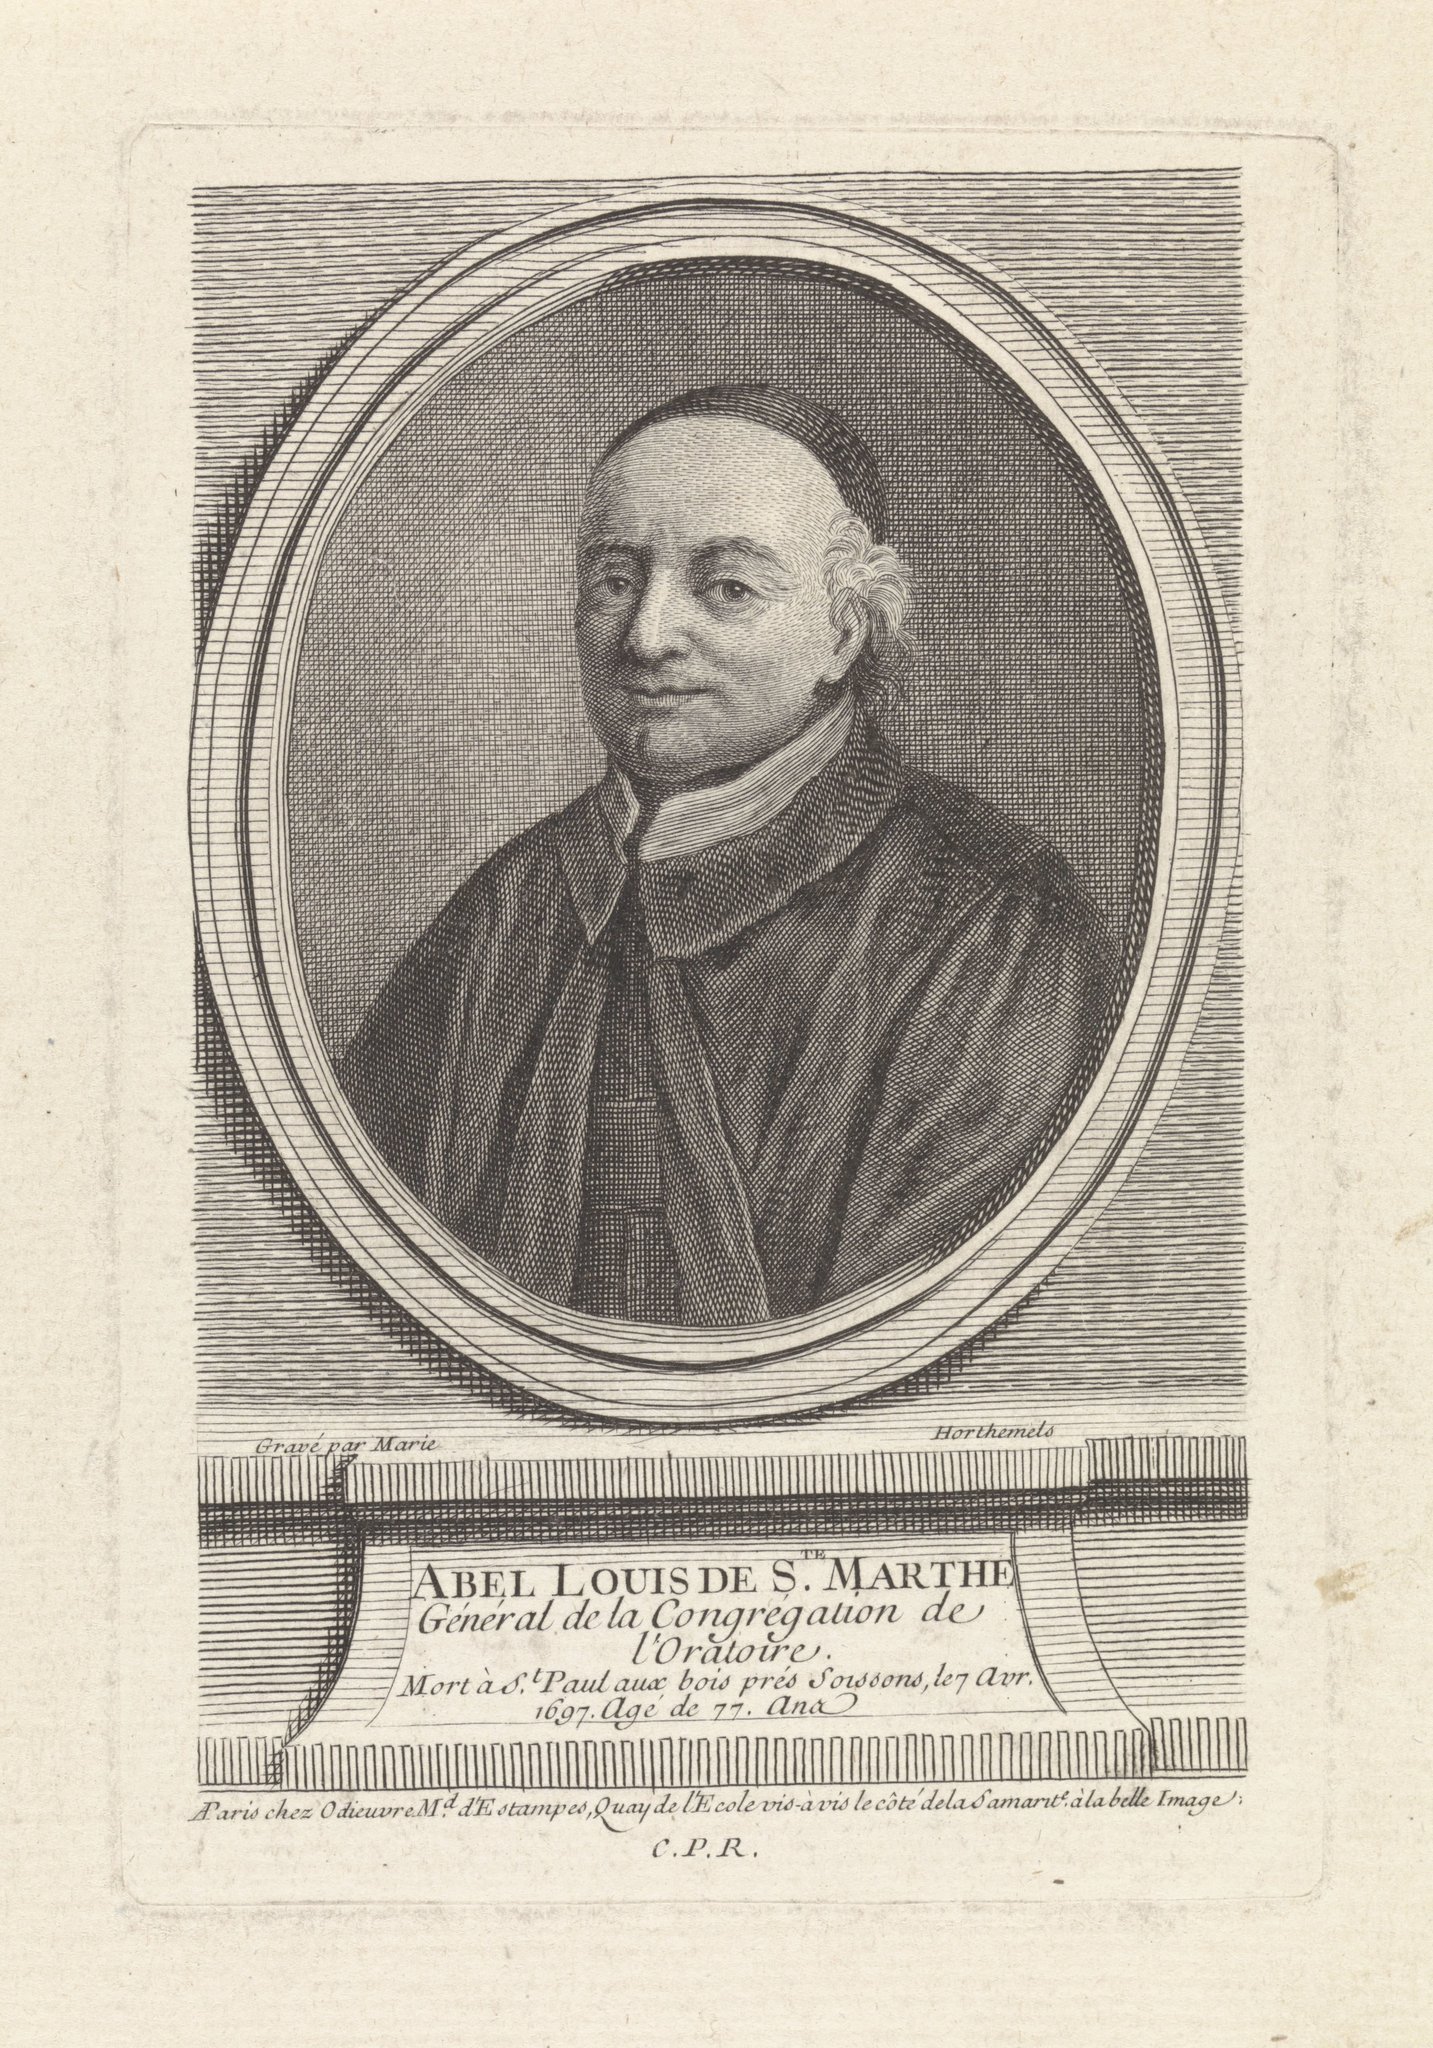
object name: print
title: Portret van Abel-Louis de Sainte-Marthe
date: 1697-1756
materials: paper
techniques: engraving, etching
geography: paris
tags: abel-louis sainte-marthe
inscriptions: collector's mark: Lugt 2228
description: Portret van de Franse geestelijke Abel-Louis de Sainte-Marthe.